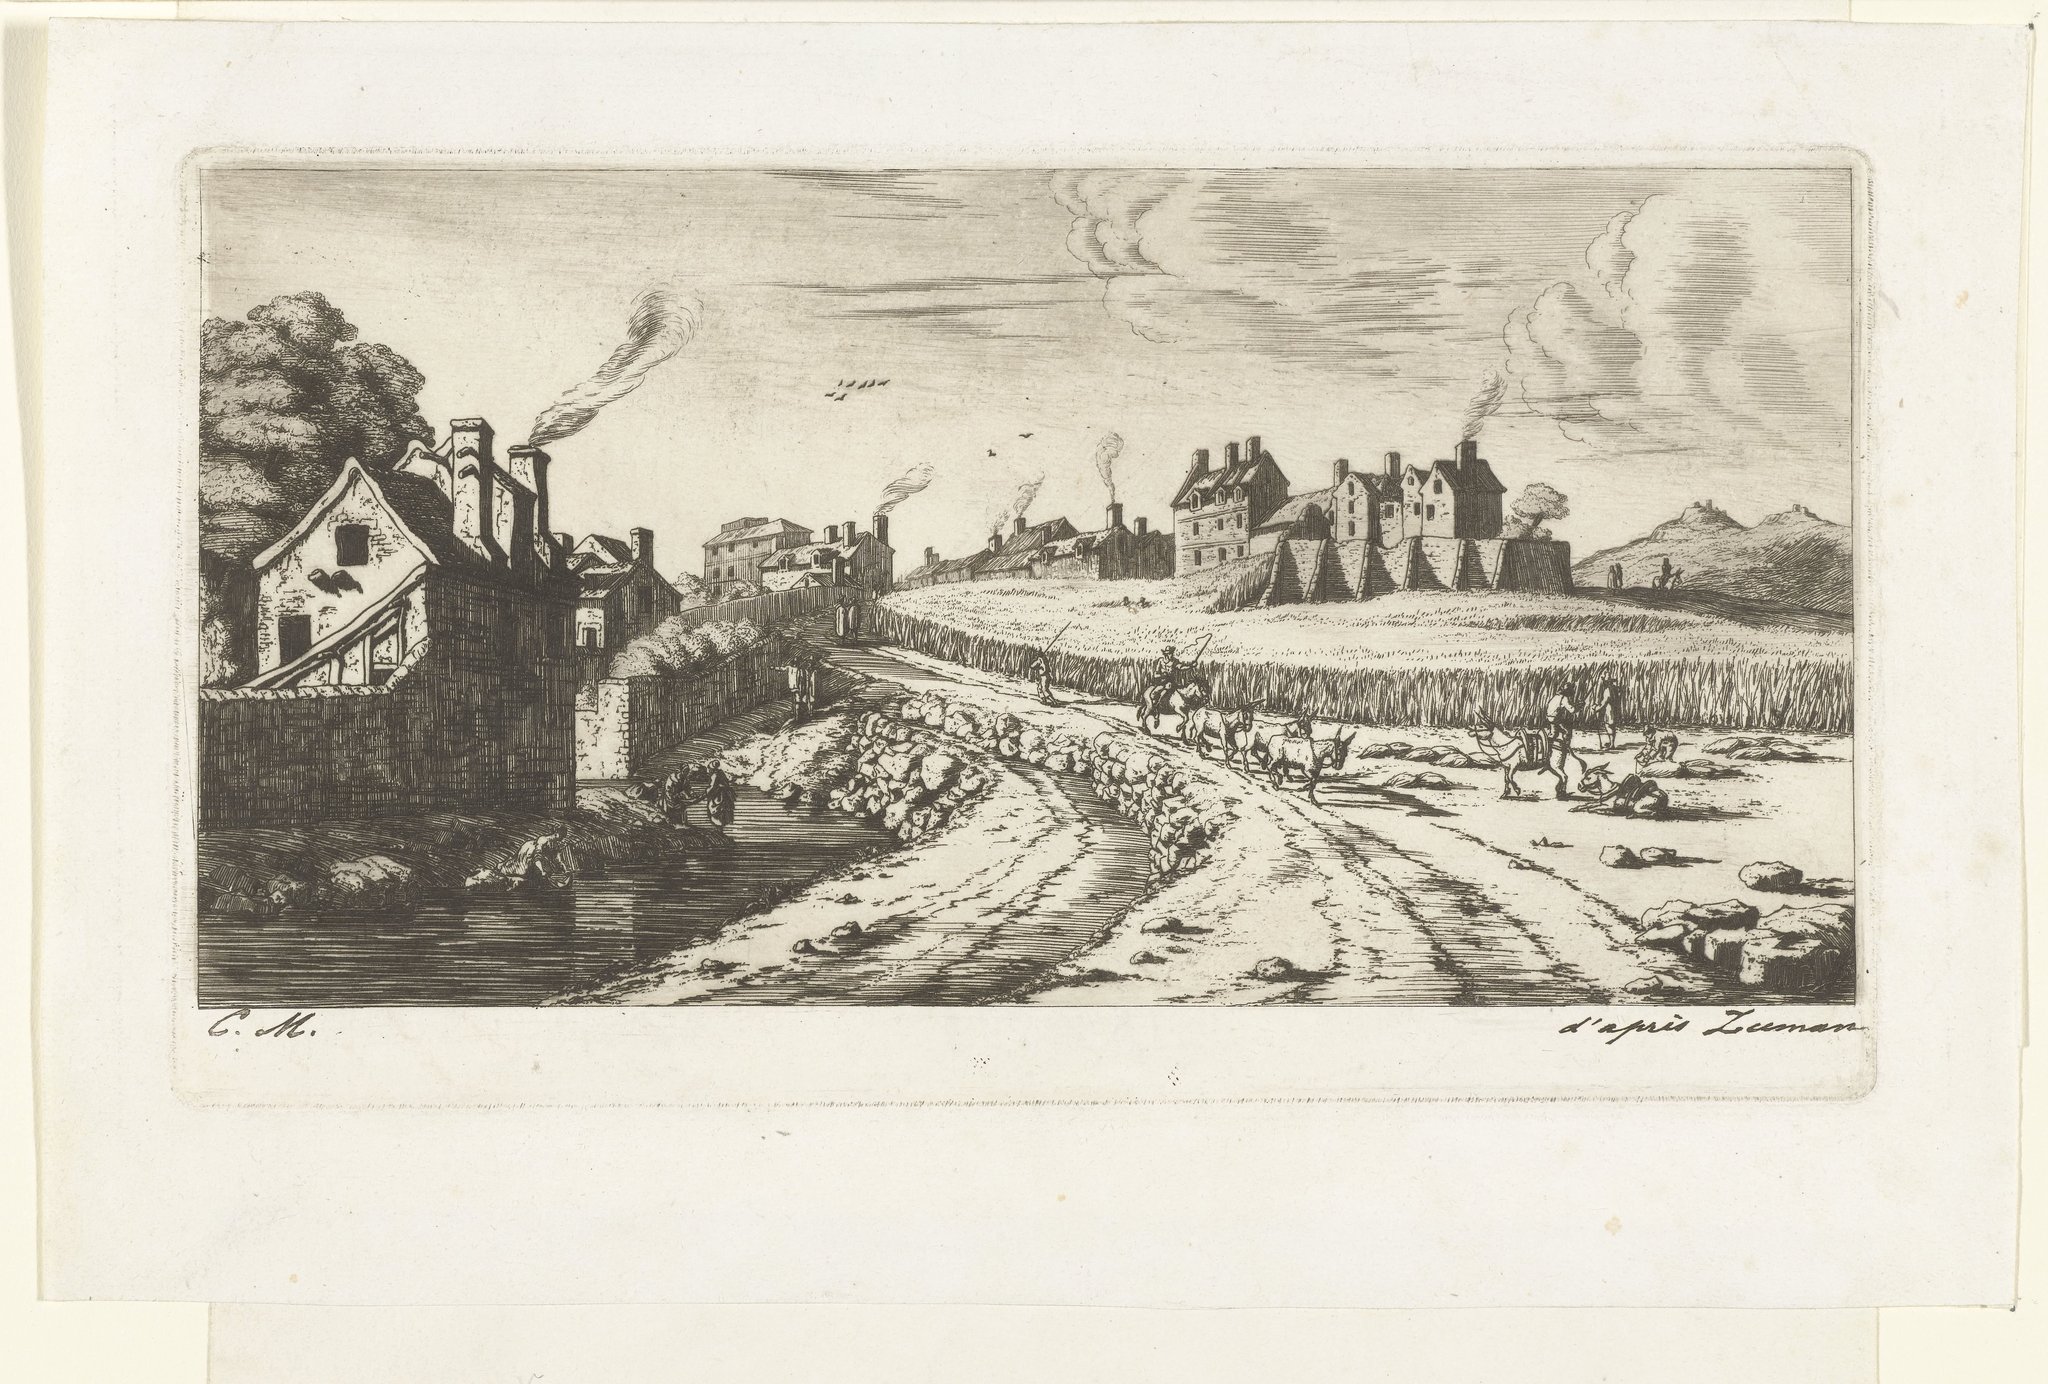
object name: print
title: Entrée du Faubourg Saint-Marceau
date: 1850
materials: paper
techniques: etching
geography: france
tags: public road, paris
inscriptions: collector's mark: Lugt 2228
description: Landschap aan de rand van de voorstad Saint-Marceau bij Parijs. Op de zandweg worden muildieren voortgedreven en mannen snijden korenhalmen op de akker naast de weg. Links zijn vrouwen aan het wassen bij de oever van een rivier en achter hoge muren staan huizen.